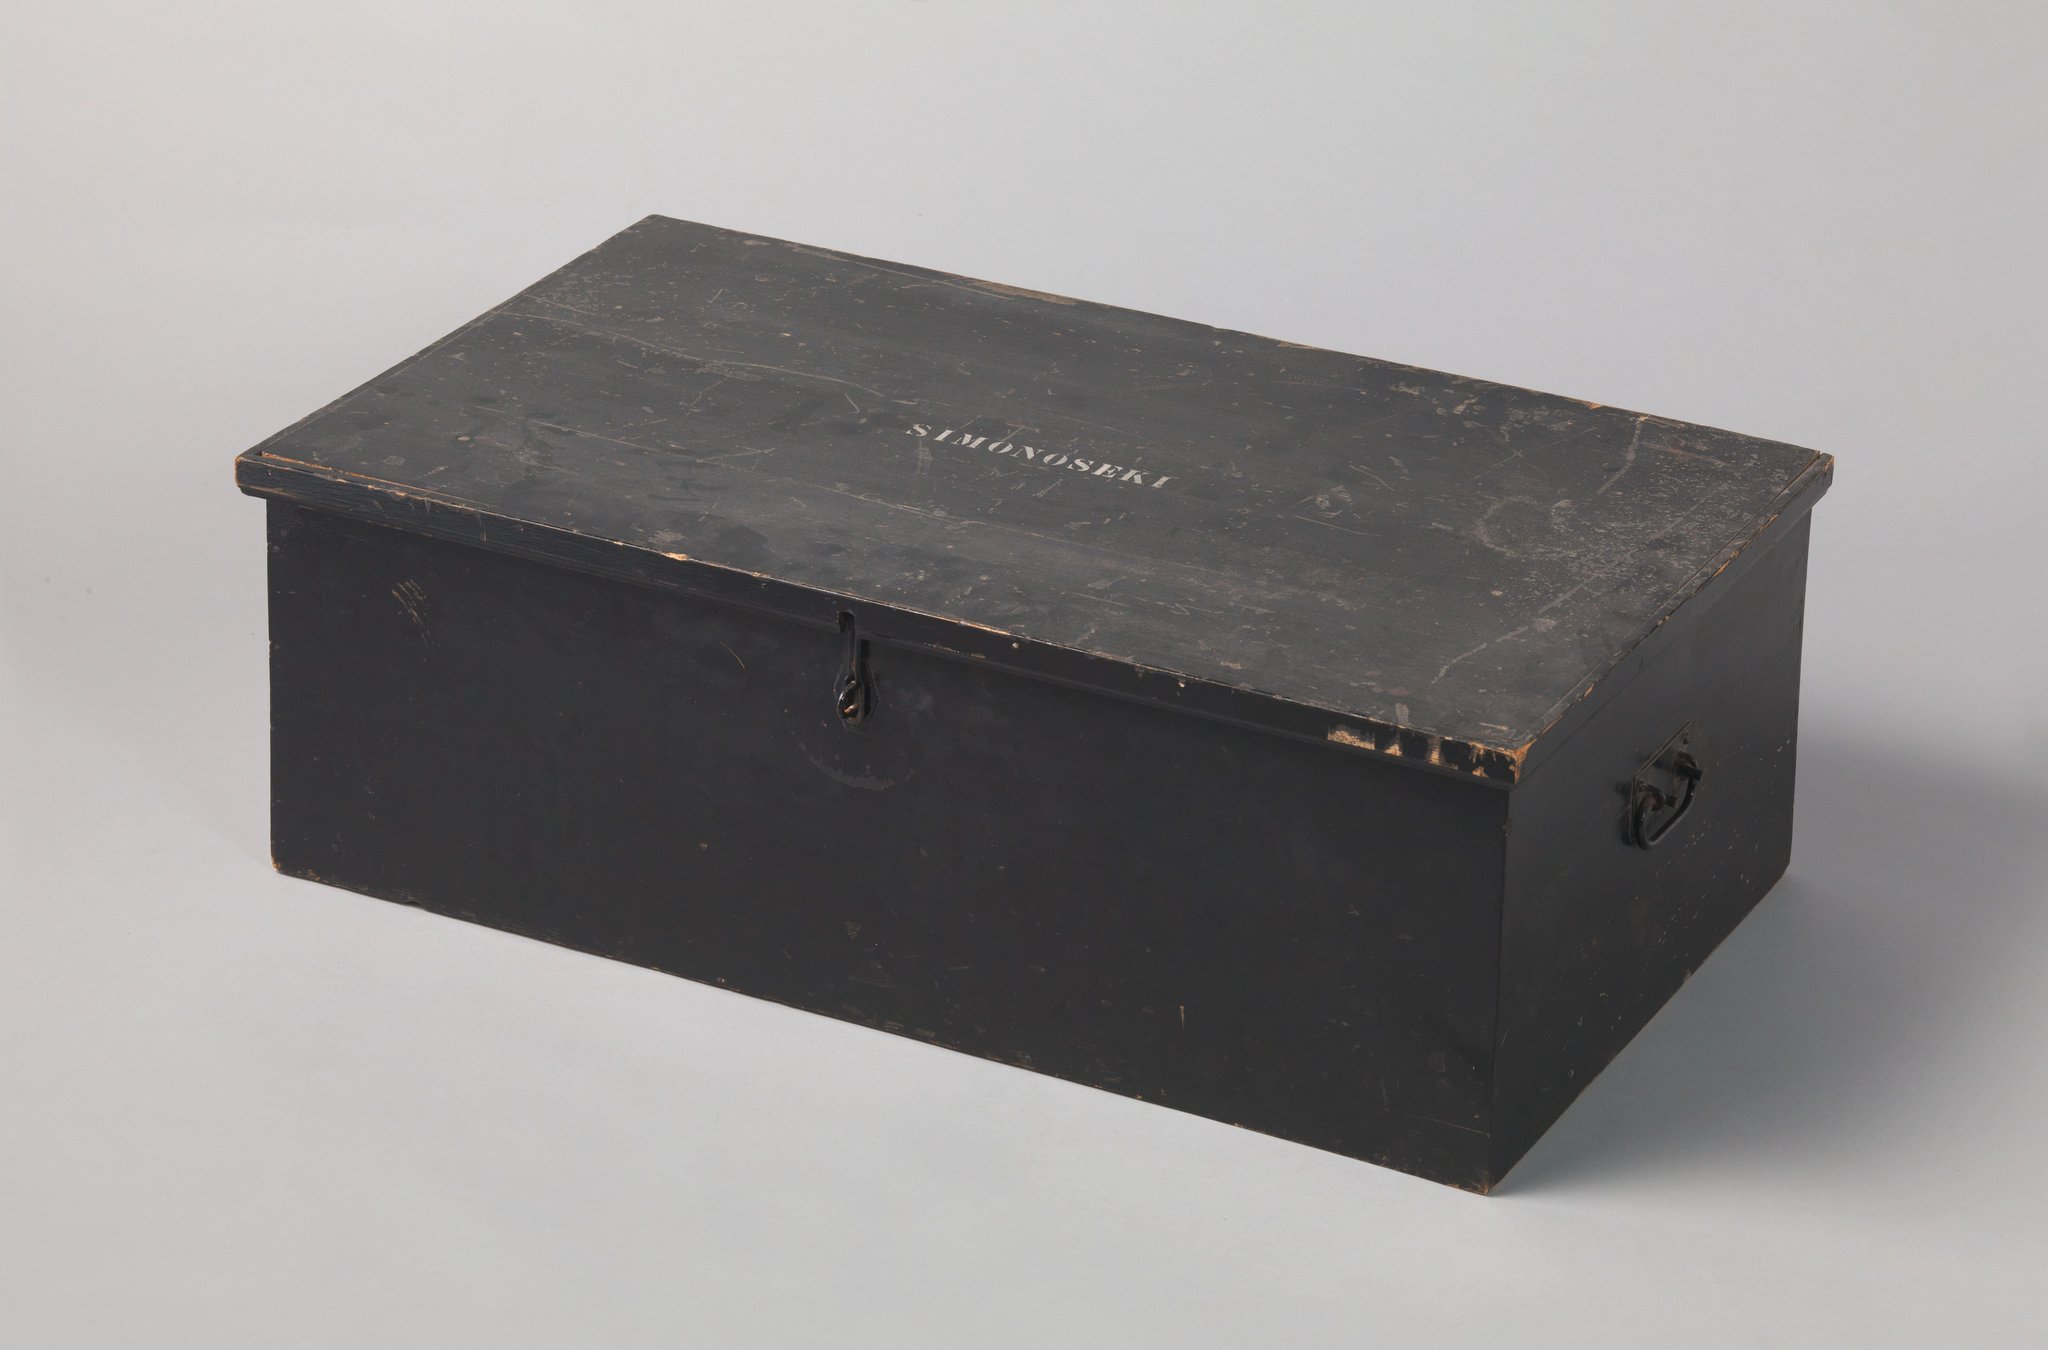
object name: sea chest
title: Kist vereniging "Het Metalen Kruis"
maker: Anonymous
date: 1850-1853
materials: iron, wood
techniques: painted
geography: netherlands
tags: metalen kruis, shimonoseki, straat van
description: Kist waarin objecten Metalen Kruis en Simonoseki bewaard zijn geweest. Aan de zijkanten hengels. Op deksel met sjabloon letters staat SIMONOSEKI. Aan de binnenzijde van de deksel met potlood: zijden vlaggen Metalen Kruis Simonoseki. Album huldeblijk van ingezetenen van Den Haag aangeboden aan J.W. de Casembroot februari 1865.